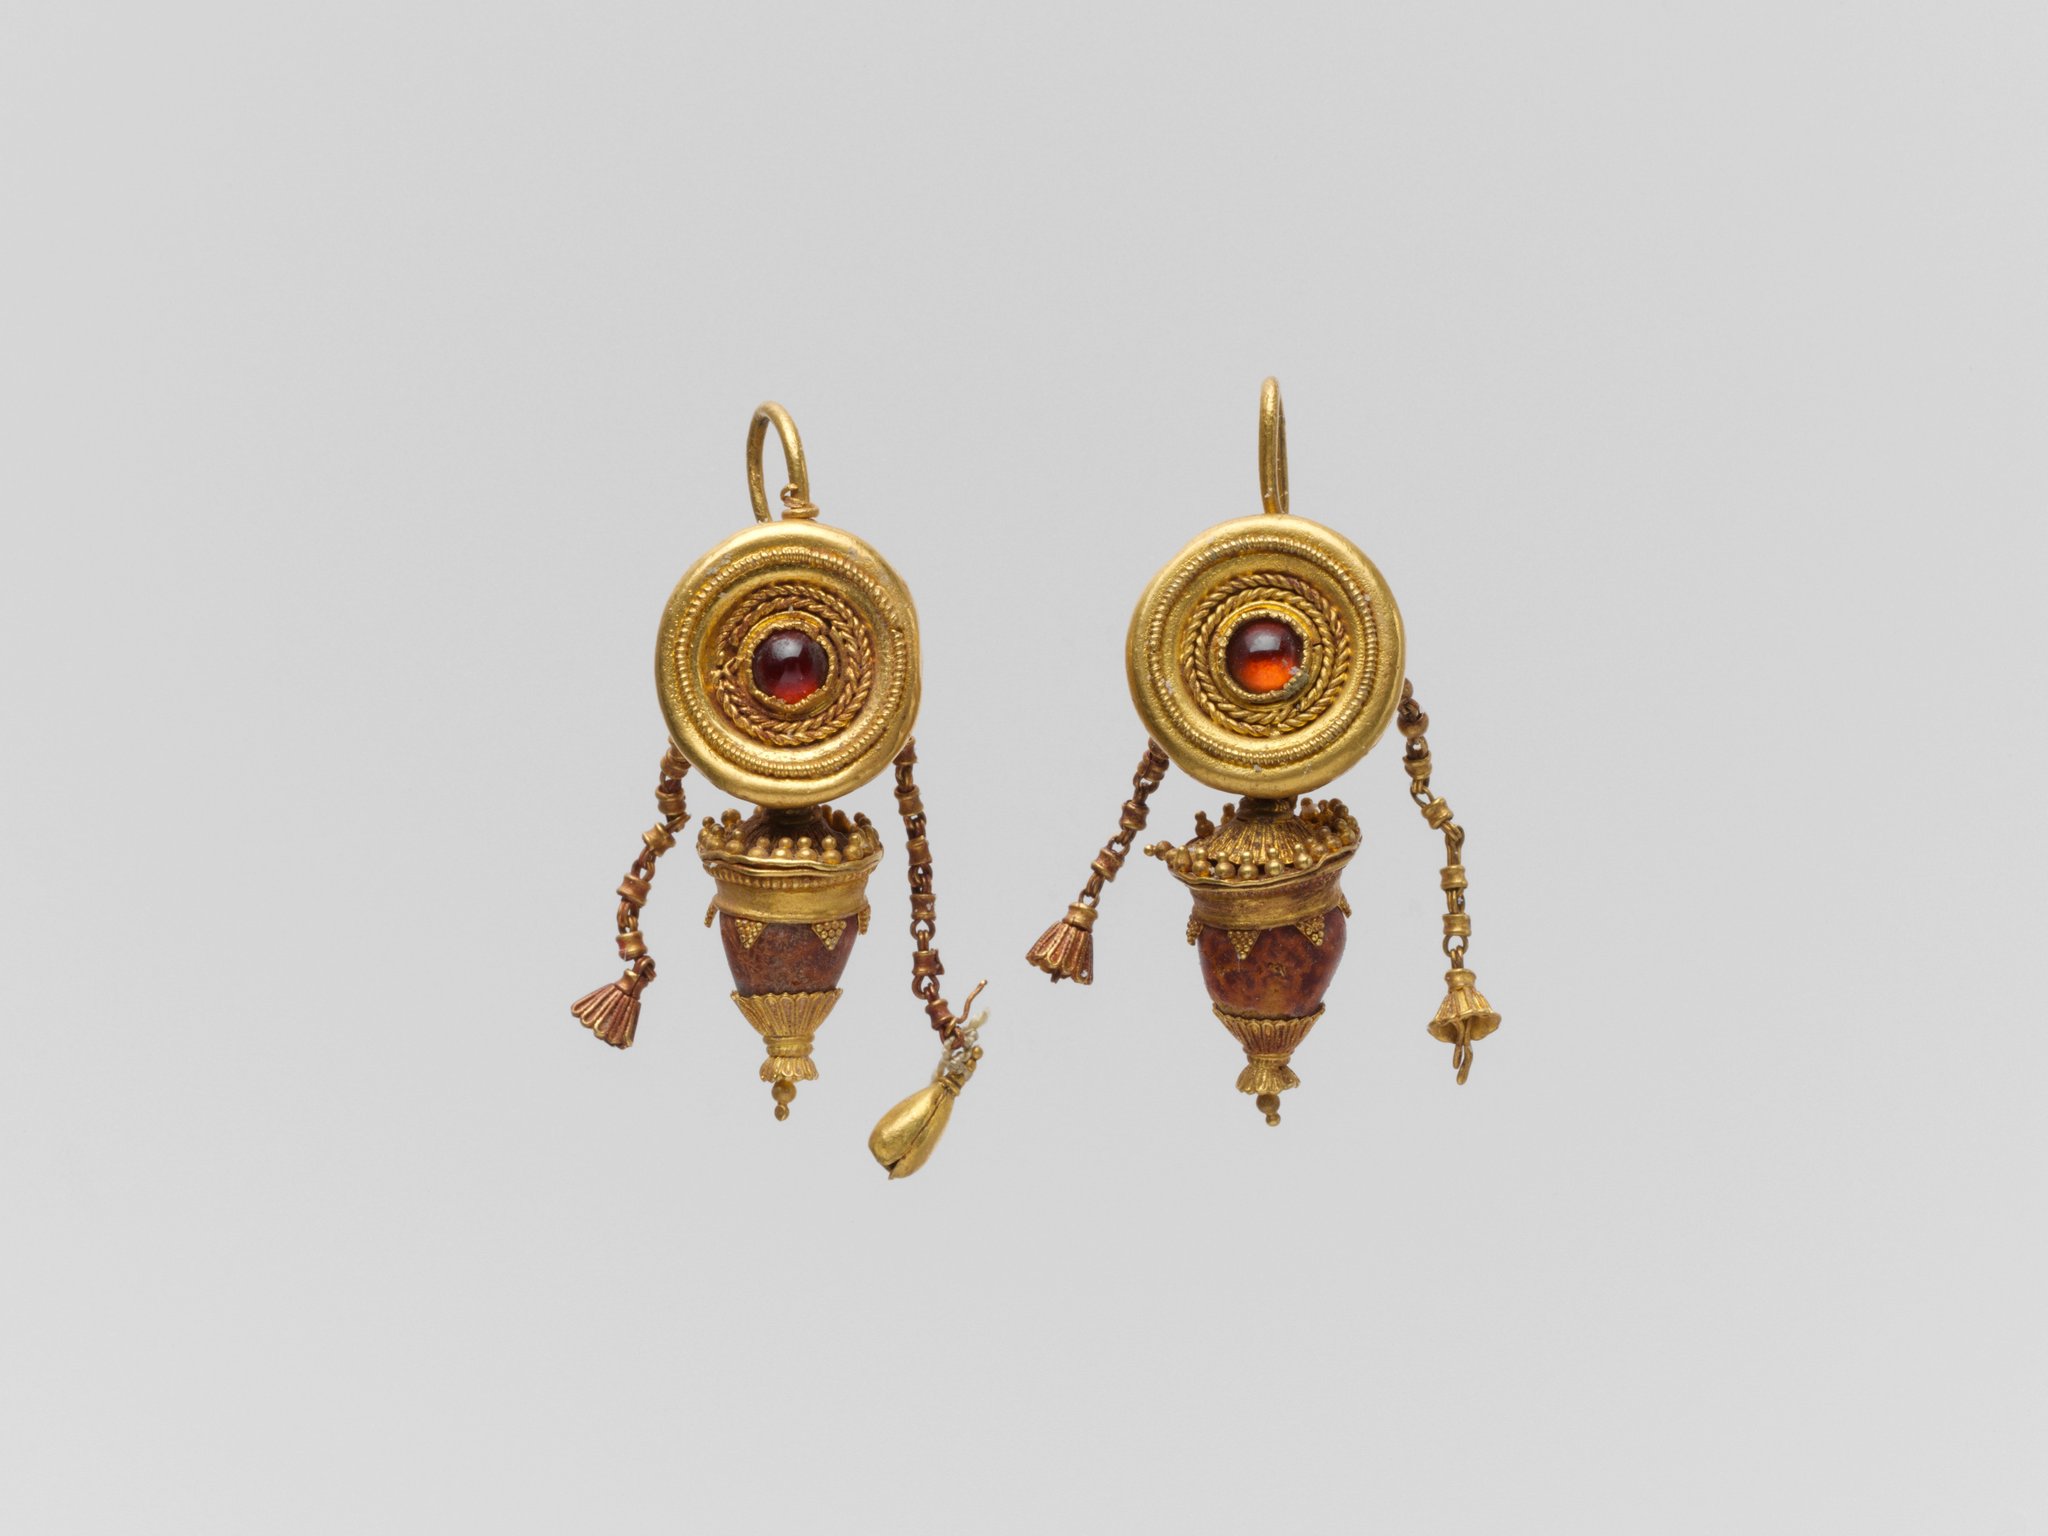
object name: earring with disc, chain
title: Pair of gold, garnet, and glass paste disk and pendant earrings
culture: greek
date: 200-101 BCE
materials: gold